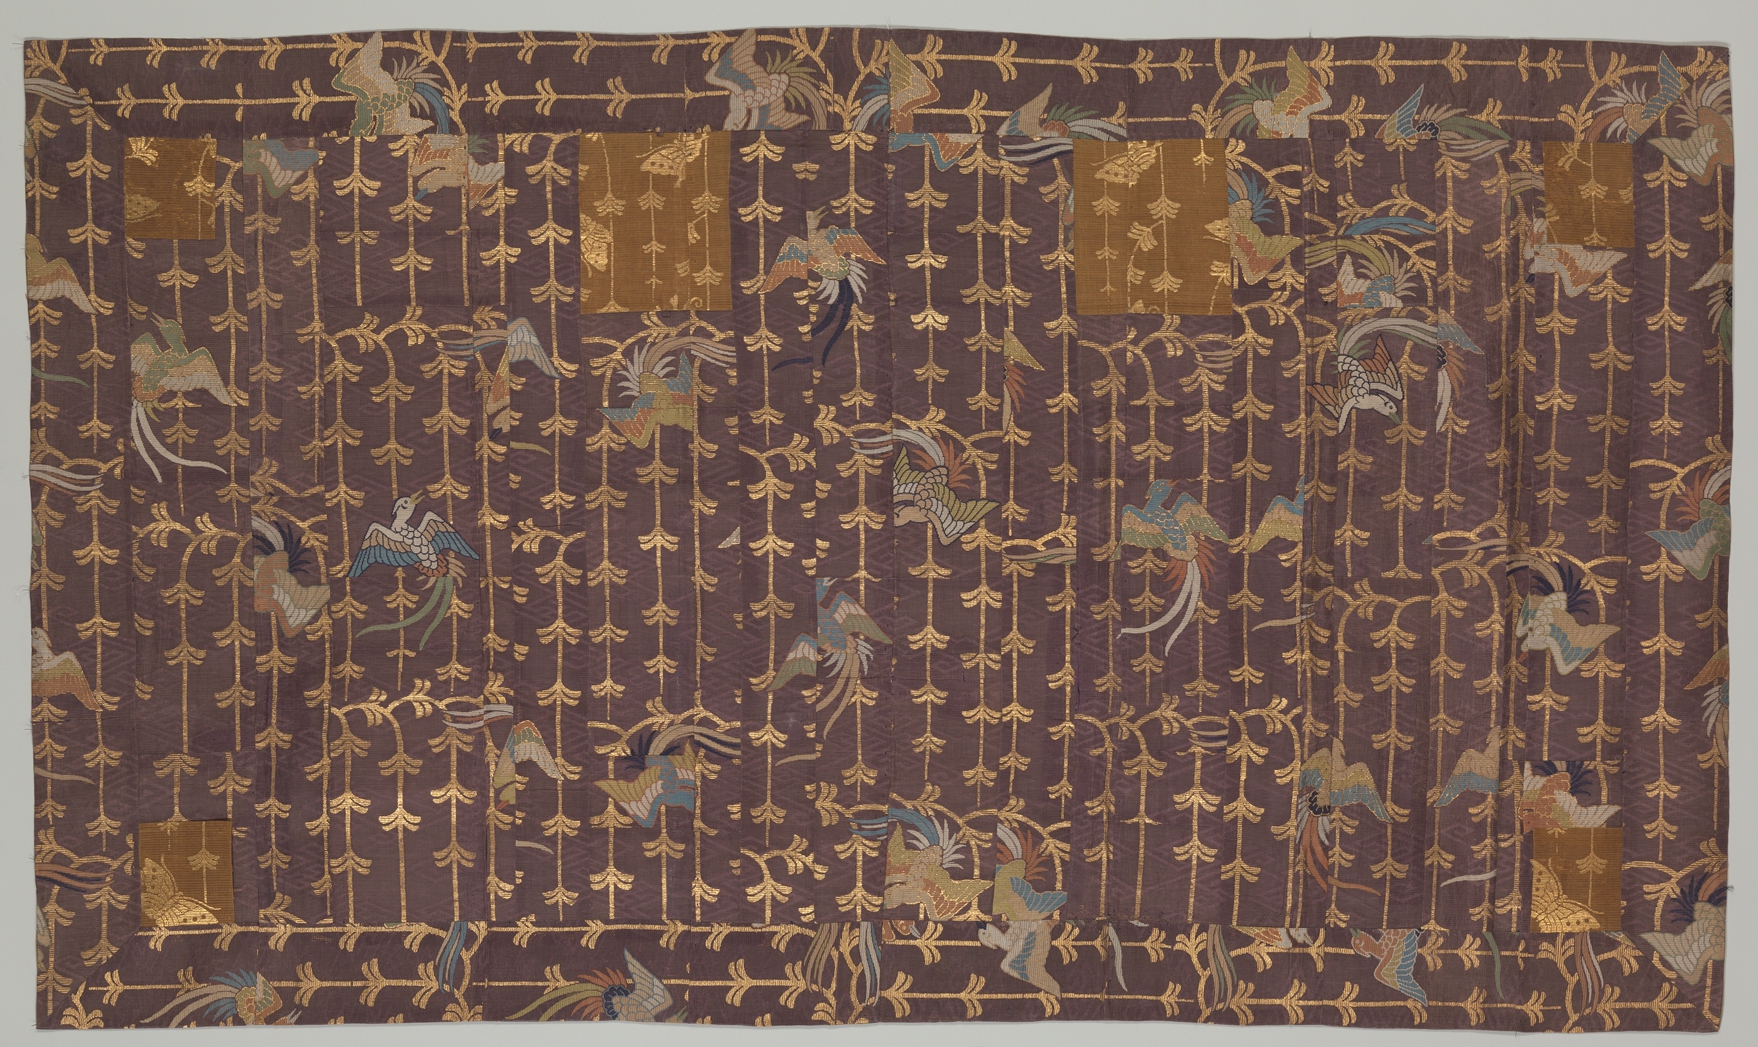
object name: robe, priest's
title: Priest's Robe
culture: japanese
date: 1701-1900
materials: metal thread, silk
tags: birds